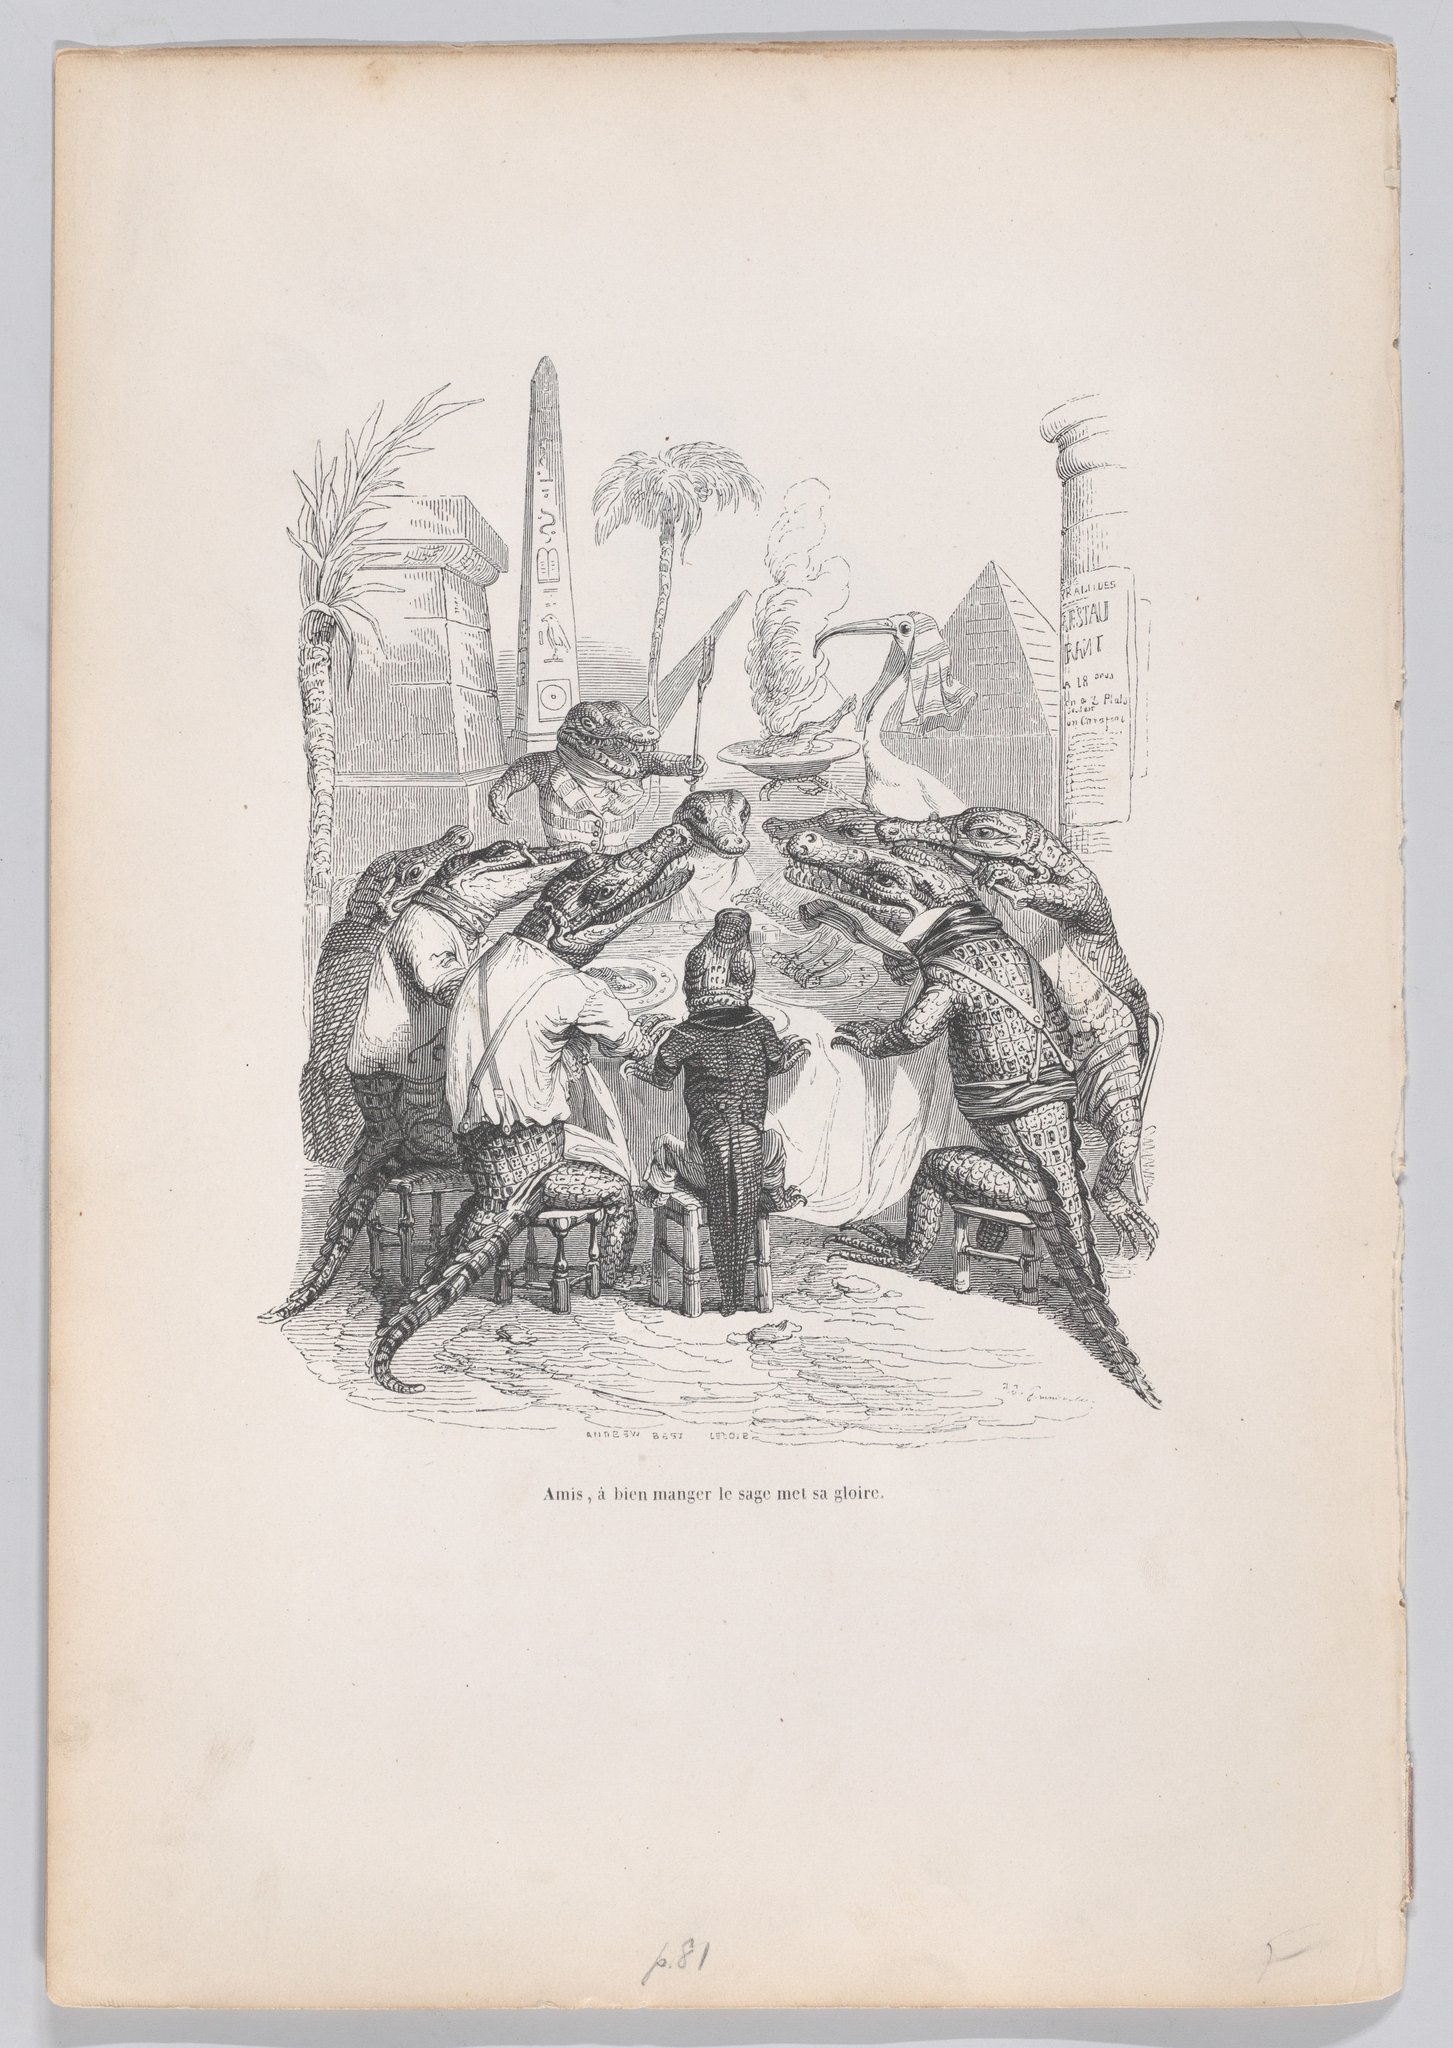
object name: print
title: Friends, the wise one places his glory in eating well, from "Scenes from the Private and Public Life of Animals"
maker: j. j. grandville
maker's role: illustrator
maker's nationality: french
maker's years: 1803-1847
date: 1837-1847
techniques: engraving